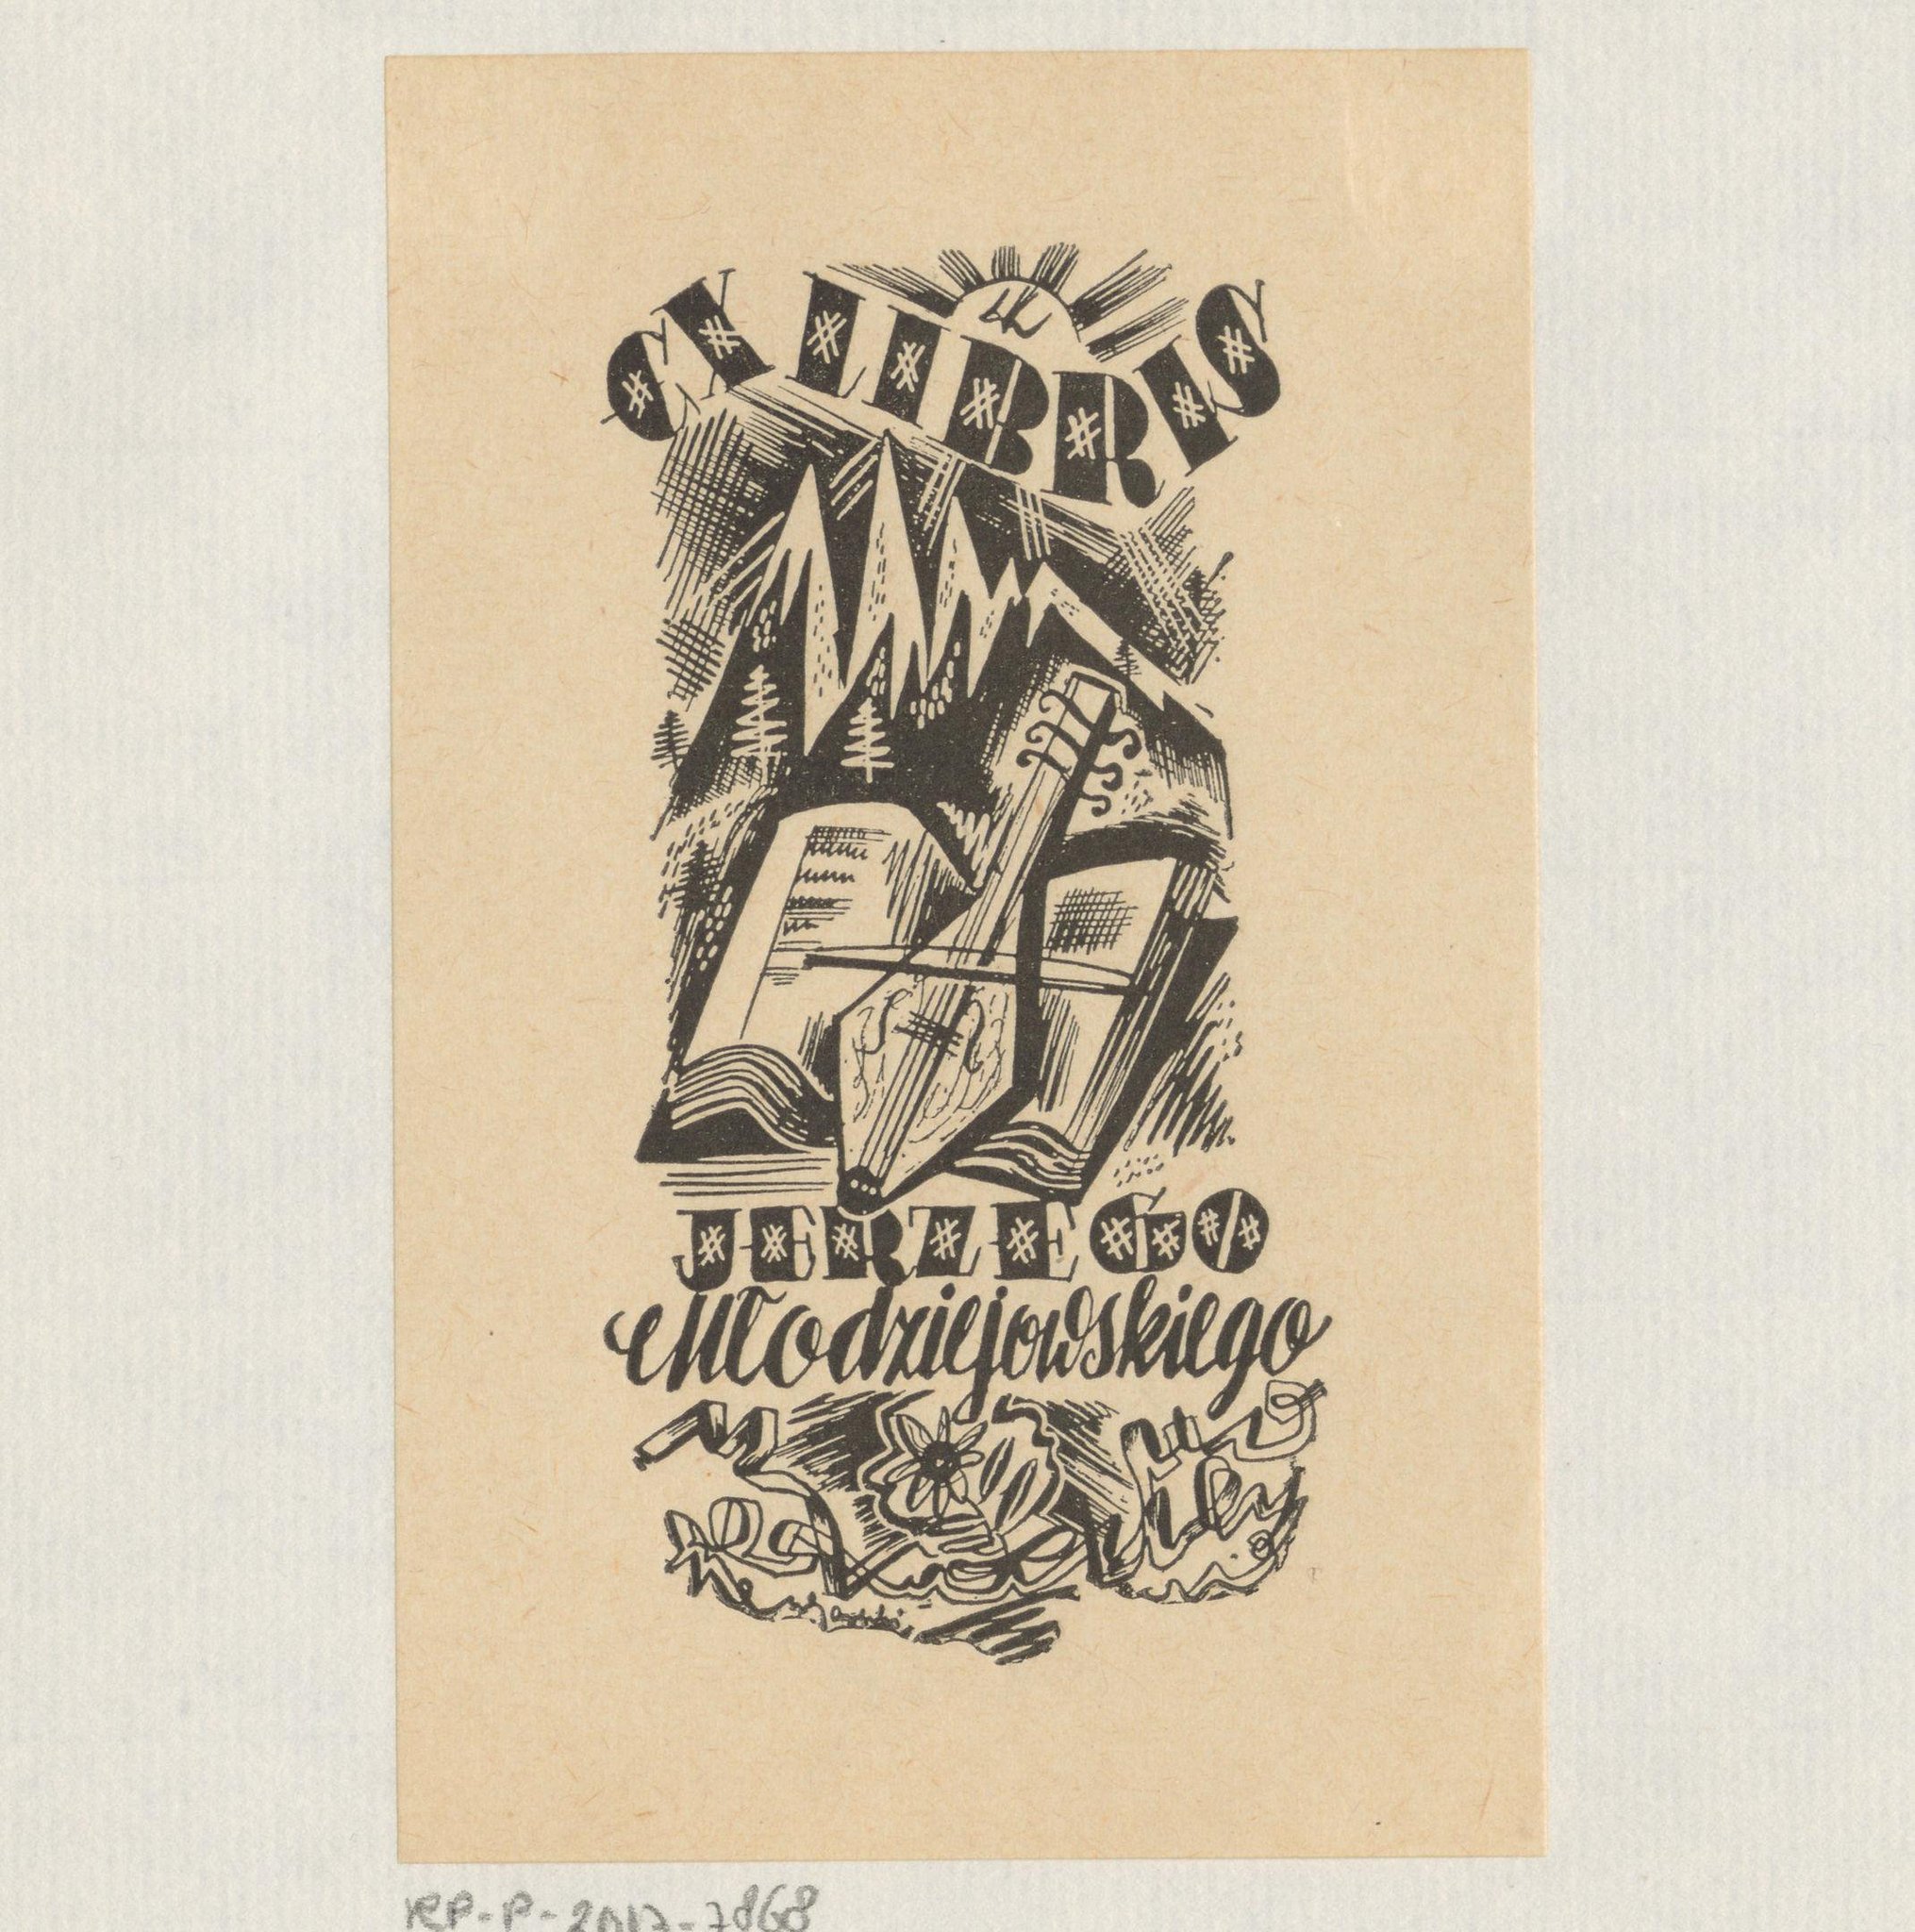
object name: bookplate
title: Ex libris van Jerzego Młodziejowski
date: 1932-1946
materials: paper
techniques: printing block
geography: poland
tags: violin, fiddle, book